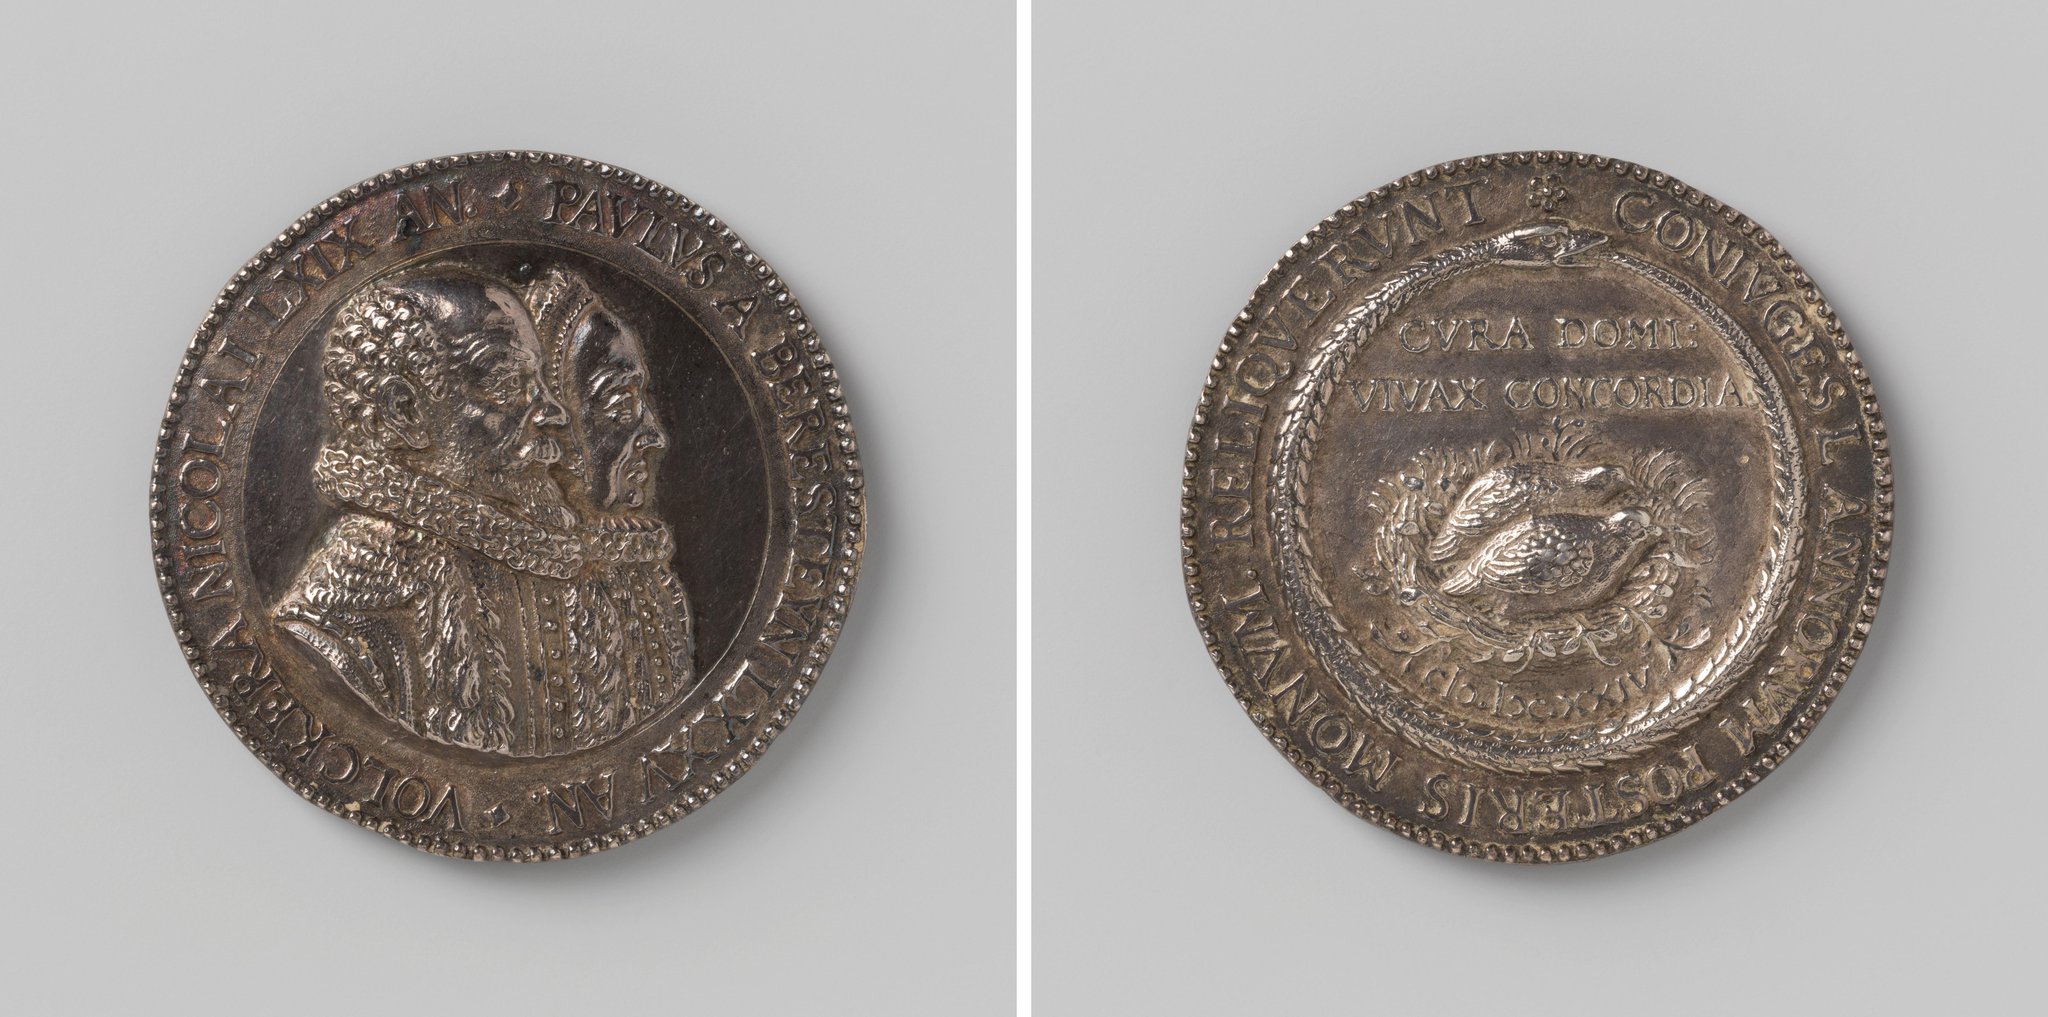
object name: family medal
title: Vijftigjarig huwelijk van Paulus van Beresteyn en Volckera Nicolai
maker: adriaen de grebber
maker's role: print maker, silversmith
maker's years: 1576-1661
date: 1624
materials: silver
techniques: casting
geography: delft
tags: mayor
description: Zilveren penning. Voorzijde: borststuk man (voor) en vrouw (achter) binnen omschrift. Keerzijde: twee vogels op nest en opschrift binnen slangerond en omschrift.